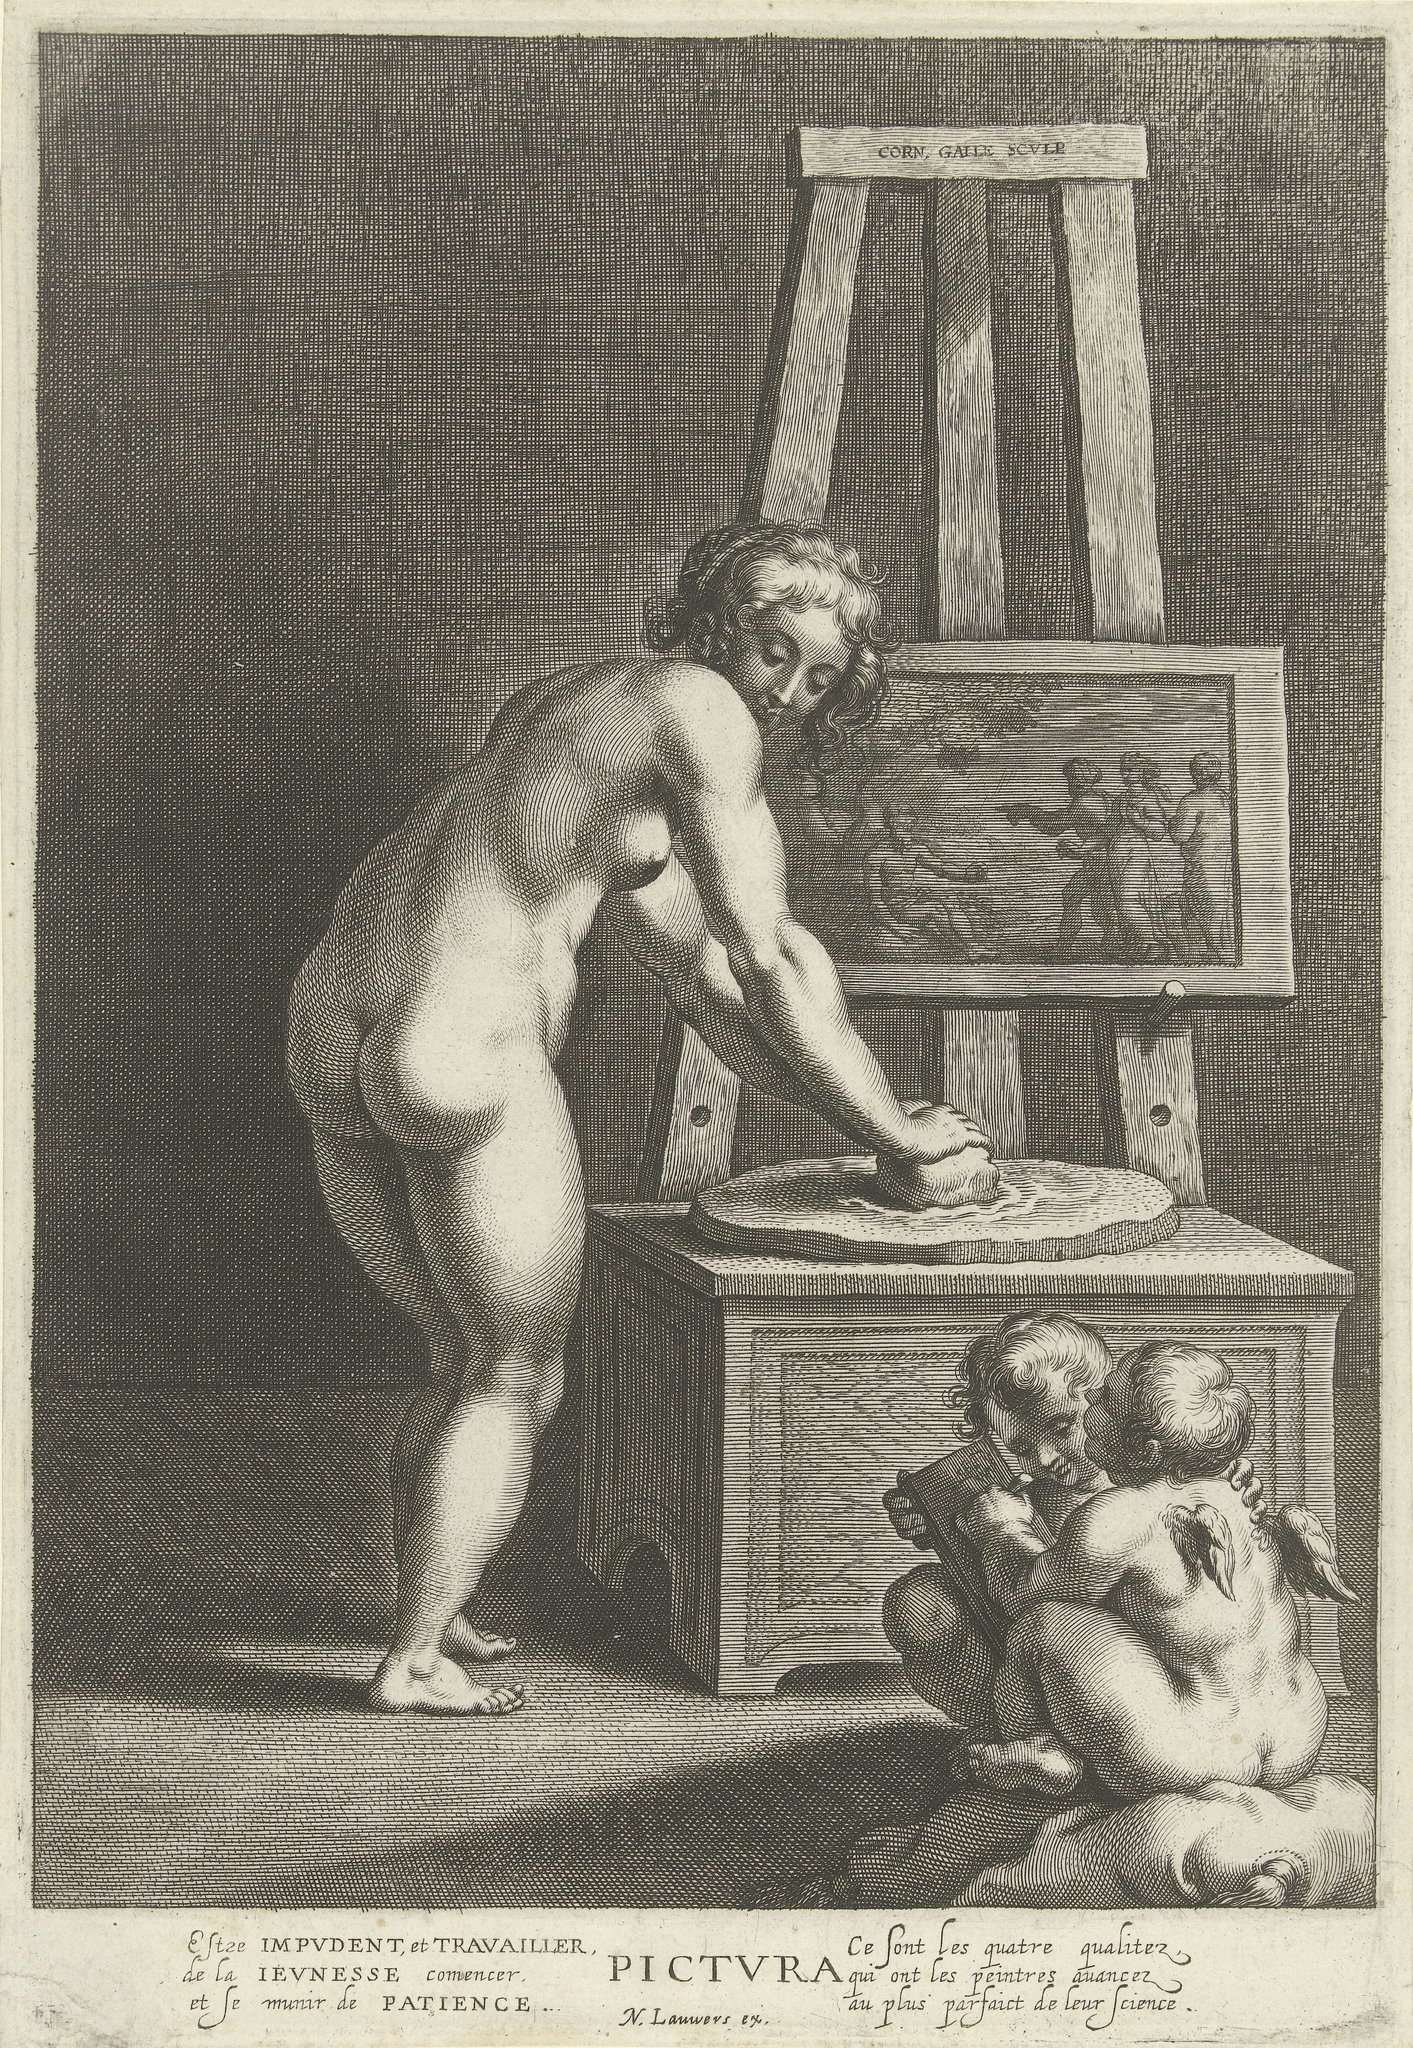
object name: print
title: Pictura (de Schilderkunst)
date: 1610-1652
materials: paper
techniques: engraving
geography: southern netherlands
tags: 'pictura', symbolic representations, allegories and emblems ~ painting; 'pittura' (ripa)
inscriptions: collector's mark: Lugt 2228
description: Pictura de personificatie van de schilderkunst vermaalt pigmenten in haar atelier. Op een ezel staat een schilderij. Op de grond zitten twee putti die een tekening van haar maken. Onder de voorstelling een Frans vers.